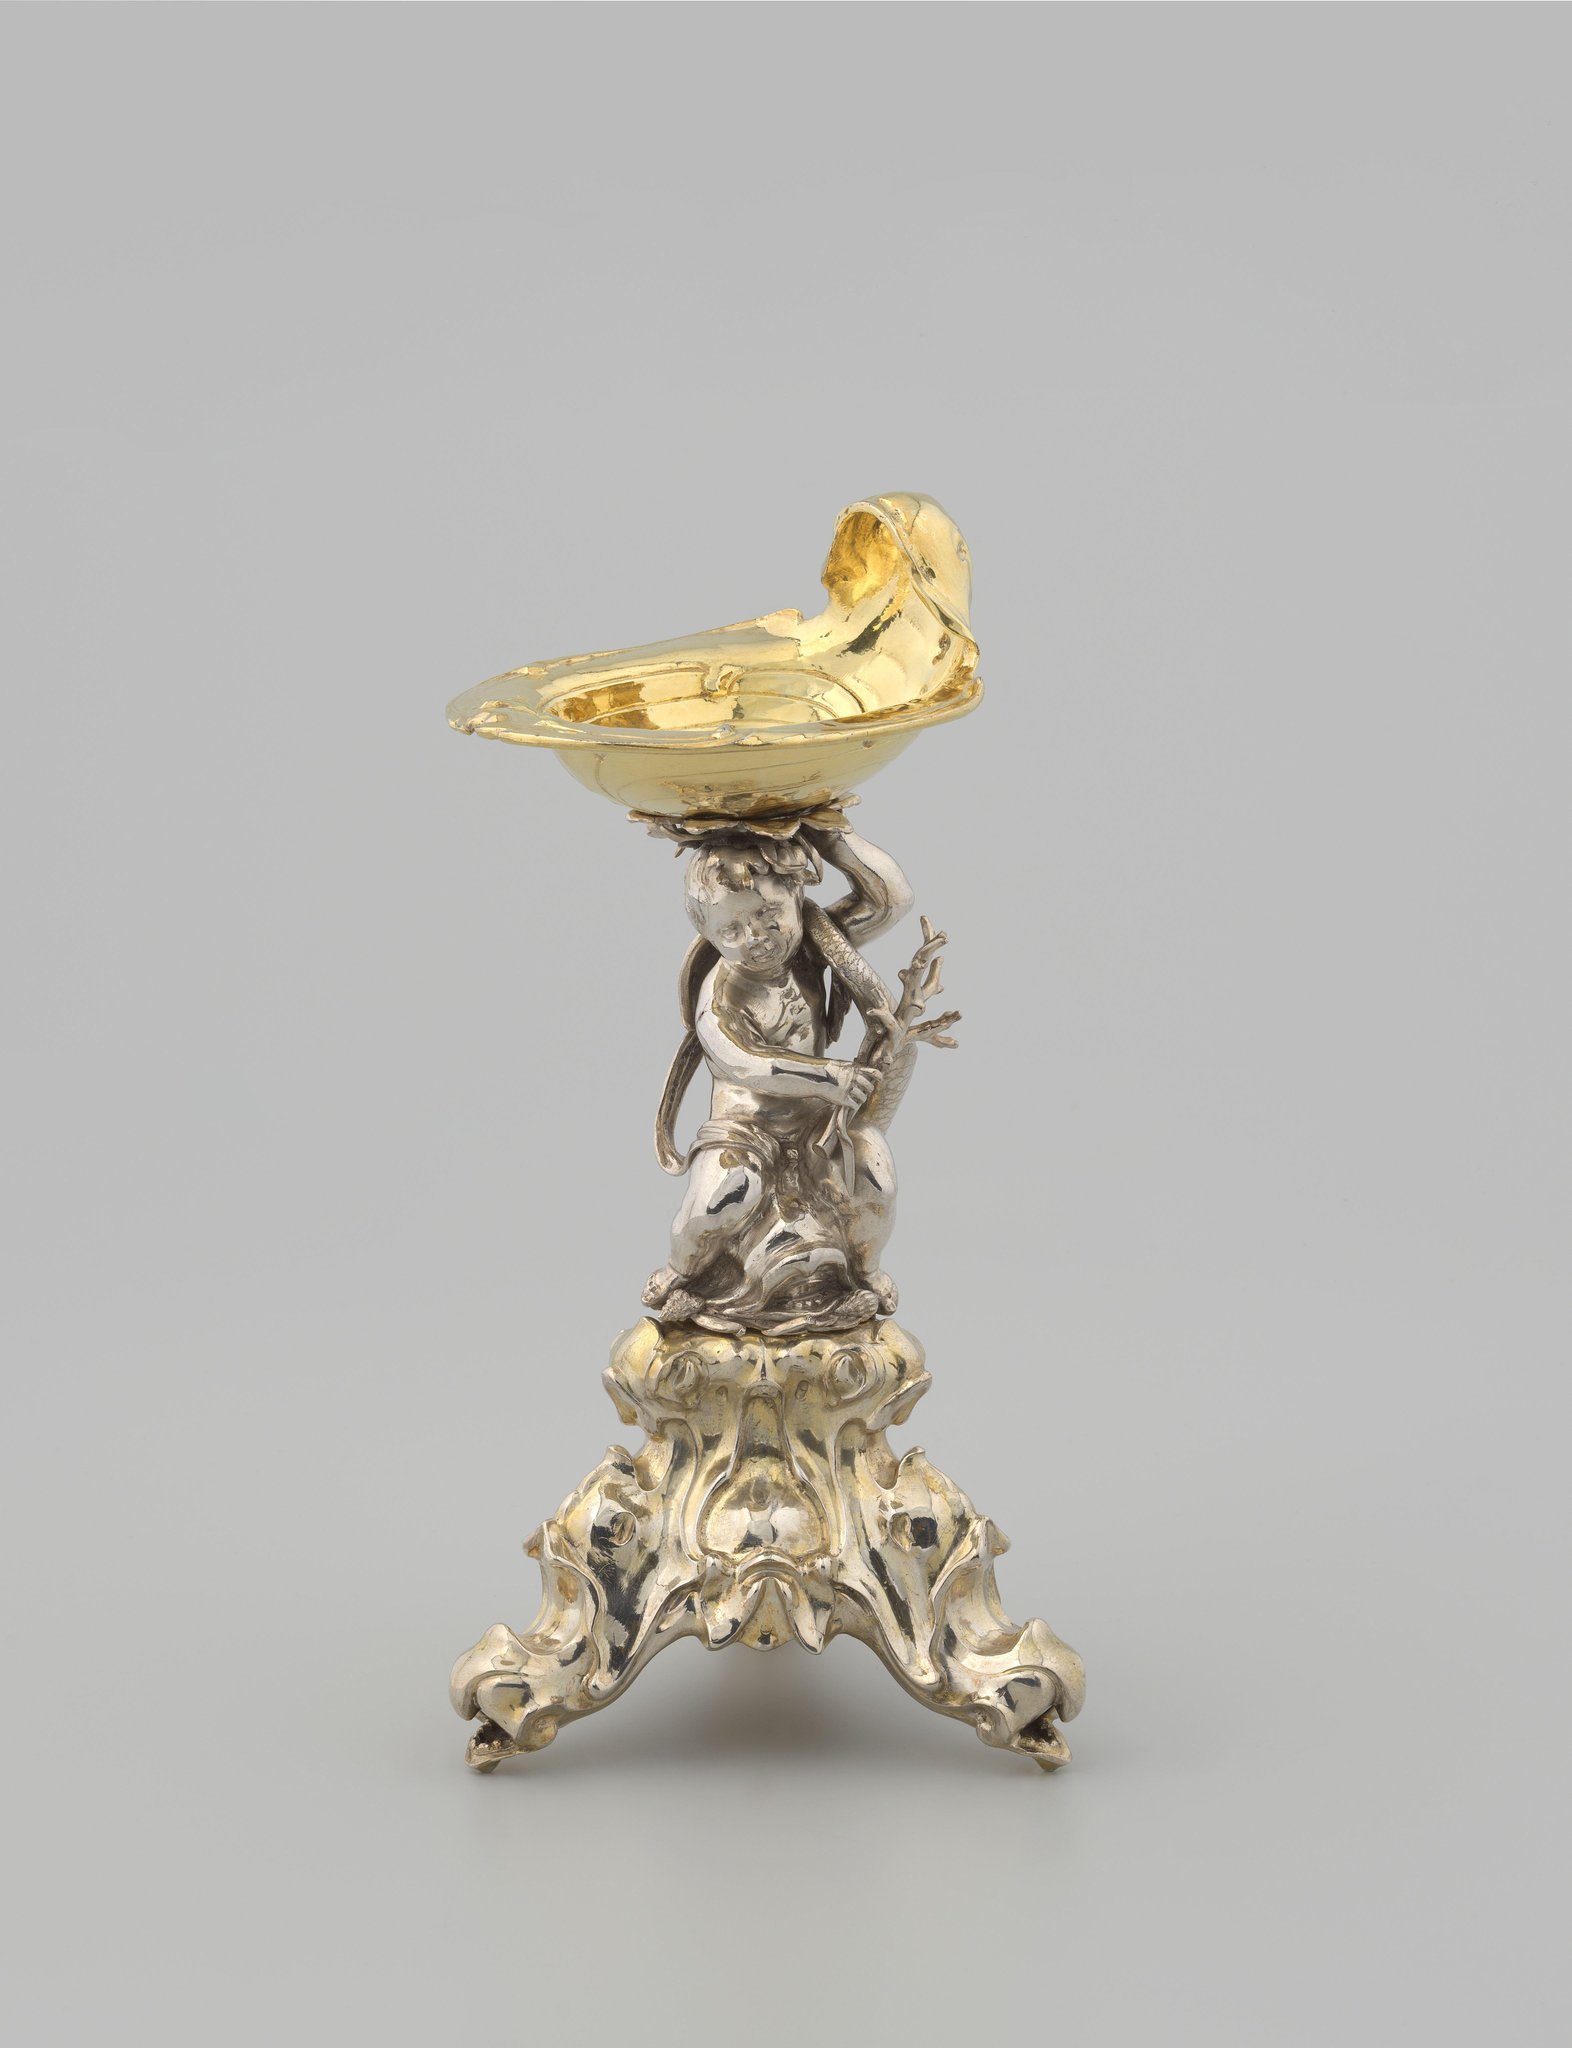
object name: salt condiment vessel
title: Two Salt Cellars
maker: johannes lutma (1584-1669)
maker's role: draughtsman, print maker, silversmith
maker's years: 1584-1669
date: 1639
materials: silver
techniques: gilding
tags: ornament derived from animal forms, dolphin ~ ornament, coelenterata: coral, scallop, shell ~ ornament, cupids: 'amores', 'amoretti', 'putti'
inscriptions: date letter: ‘H’, town mark, maker's mark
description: These salt cellars showcase the artistic influences Johannes Lutma absorbed while in Rome in 1630. Already in Roman antiquity, children were a favourite motif in sculpture, new variants of which sculptors developed in Lutma’s time. Lutma, too, created his own version, incorporating it into his salt cellars. The figure of the child follows the classical idiom, skilfully combined with fanciful auricular ornaments adorning the pedestal and bowl.